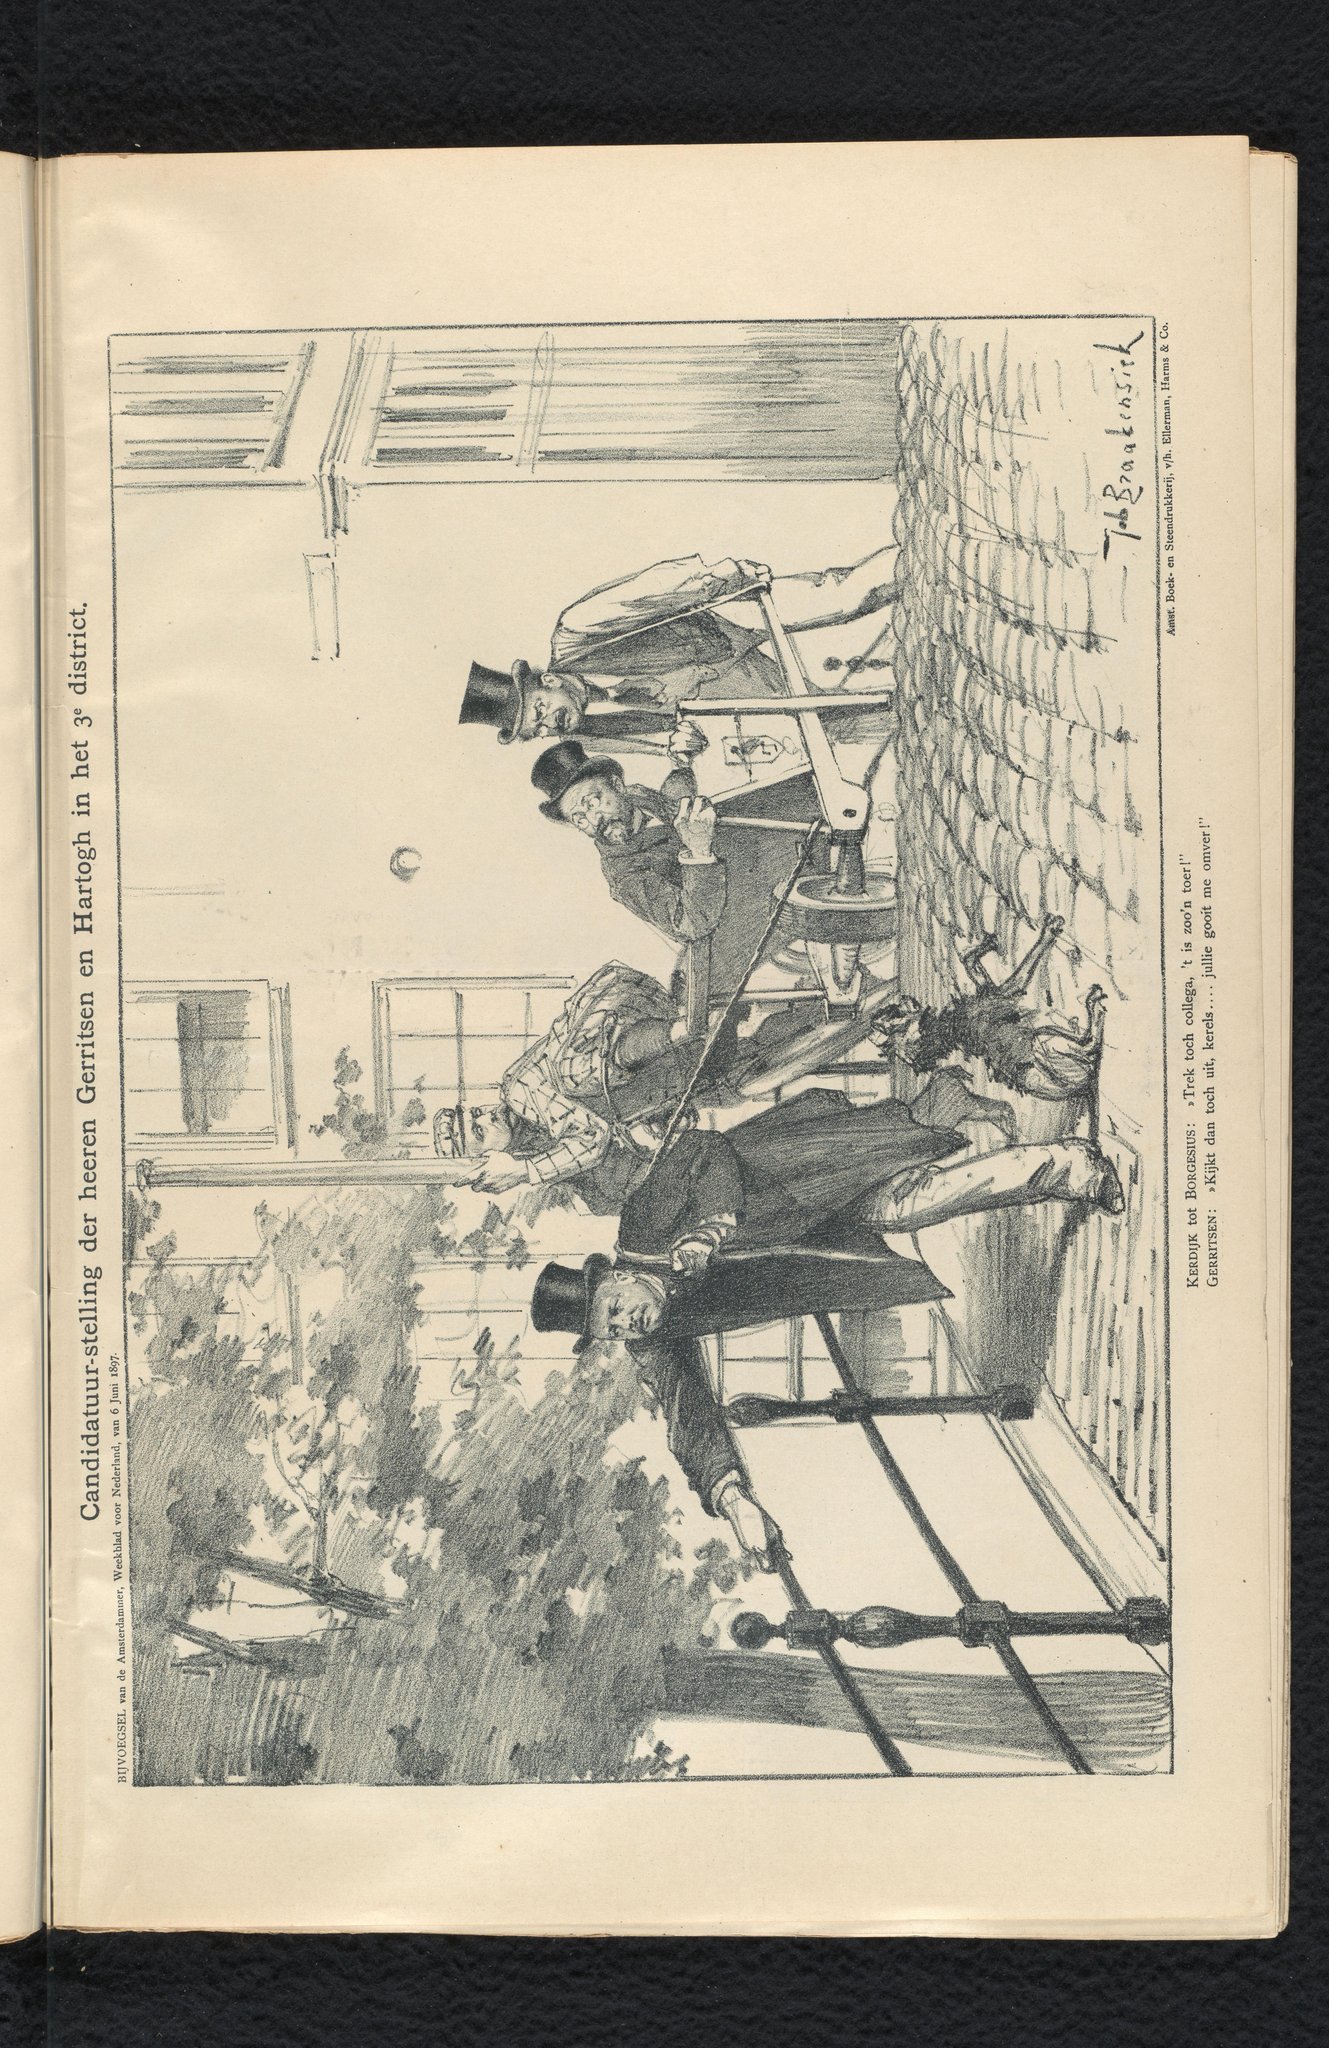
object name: cartoon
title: Candidatuur-stelling der heeren Gerritsen en Hartogh in het 3e district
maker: johan braakensiek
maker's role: draughtsman, print maker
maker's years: 1858-1940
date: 1897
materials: paper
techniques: lithograph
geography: netherlands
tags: the hague, politician, wheelbarrow, bicycle, political caricatures and satires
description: Kandidaat Abraham Hartogh wordt in een kruiwagen door Arnold Kerdijk en Hendrik Goeman Borgesius moeizaam de brug opgeduwd en getrokken. Hierbij rijden ze Carel Gerritsen van zijn fiets.